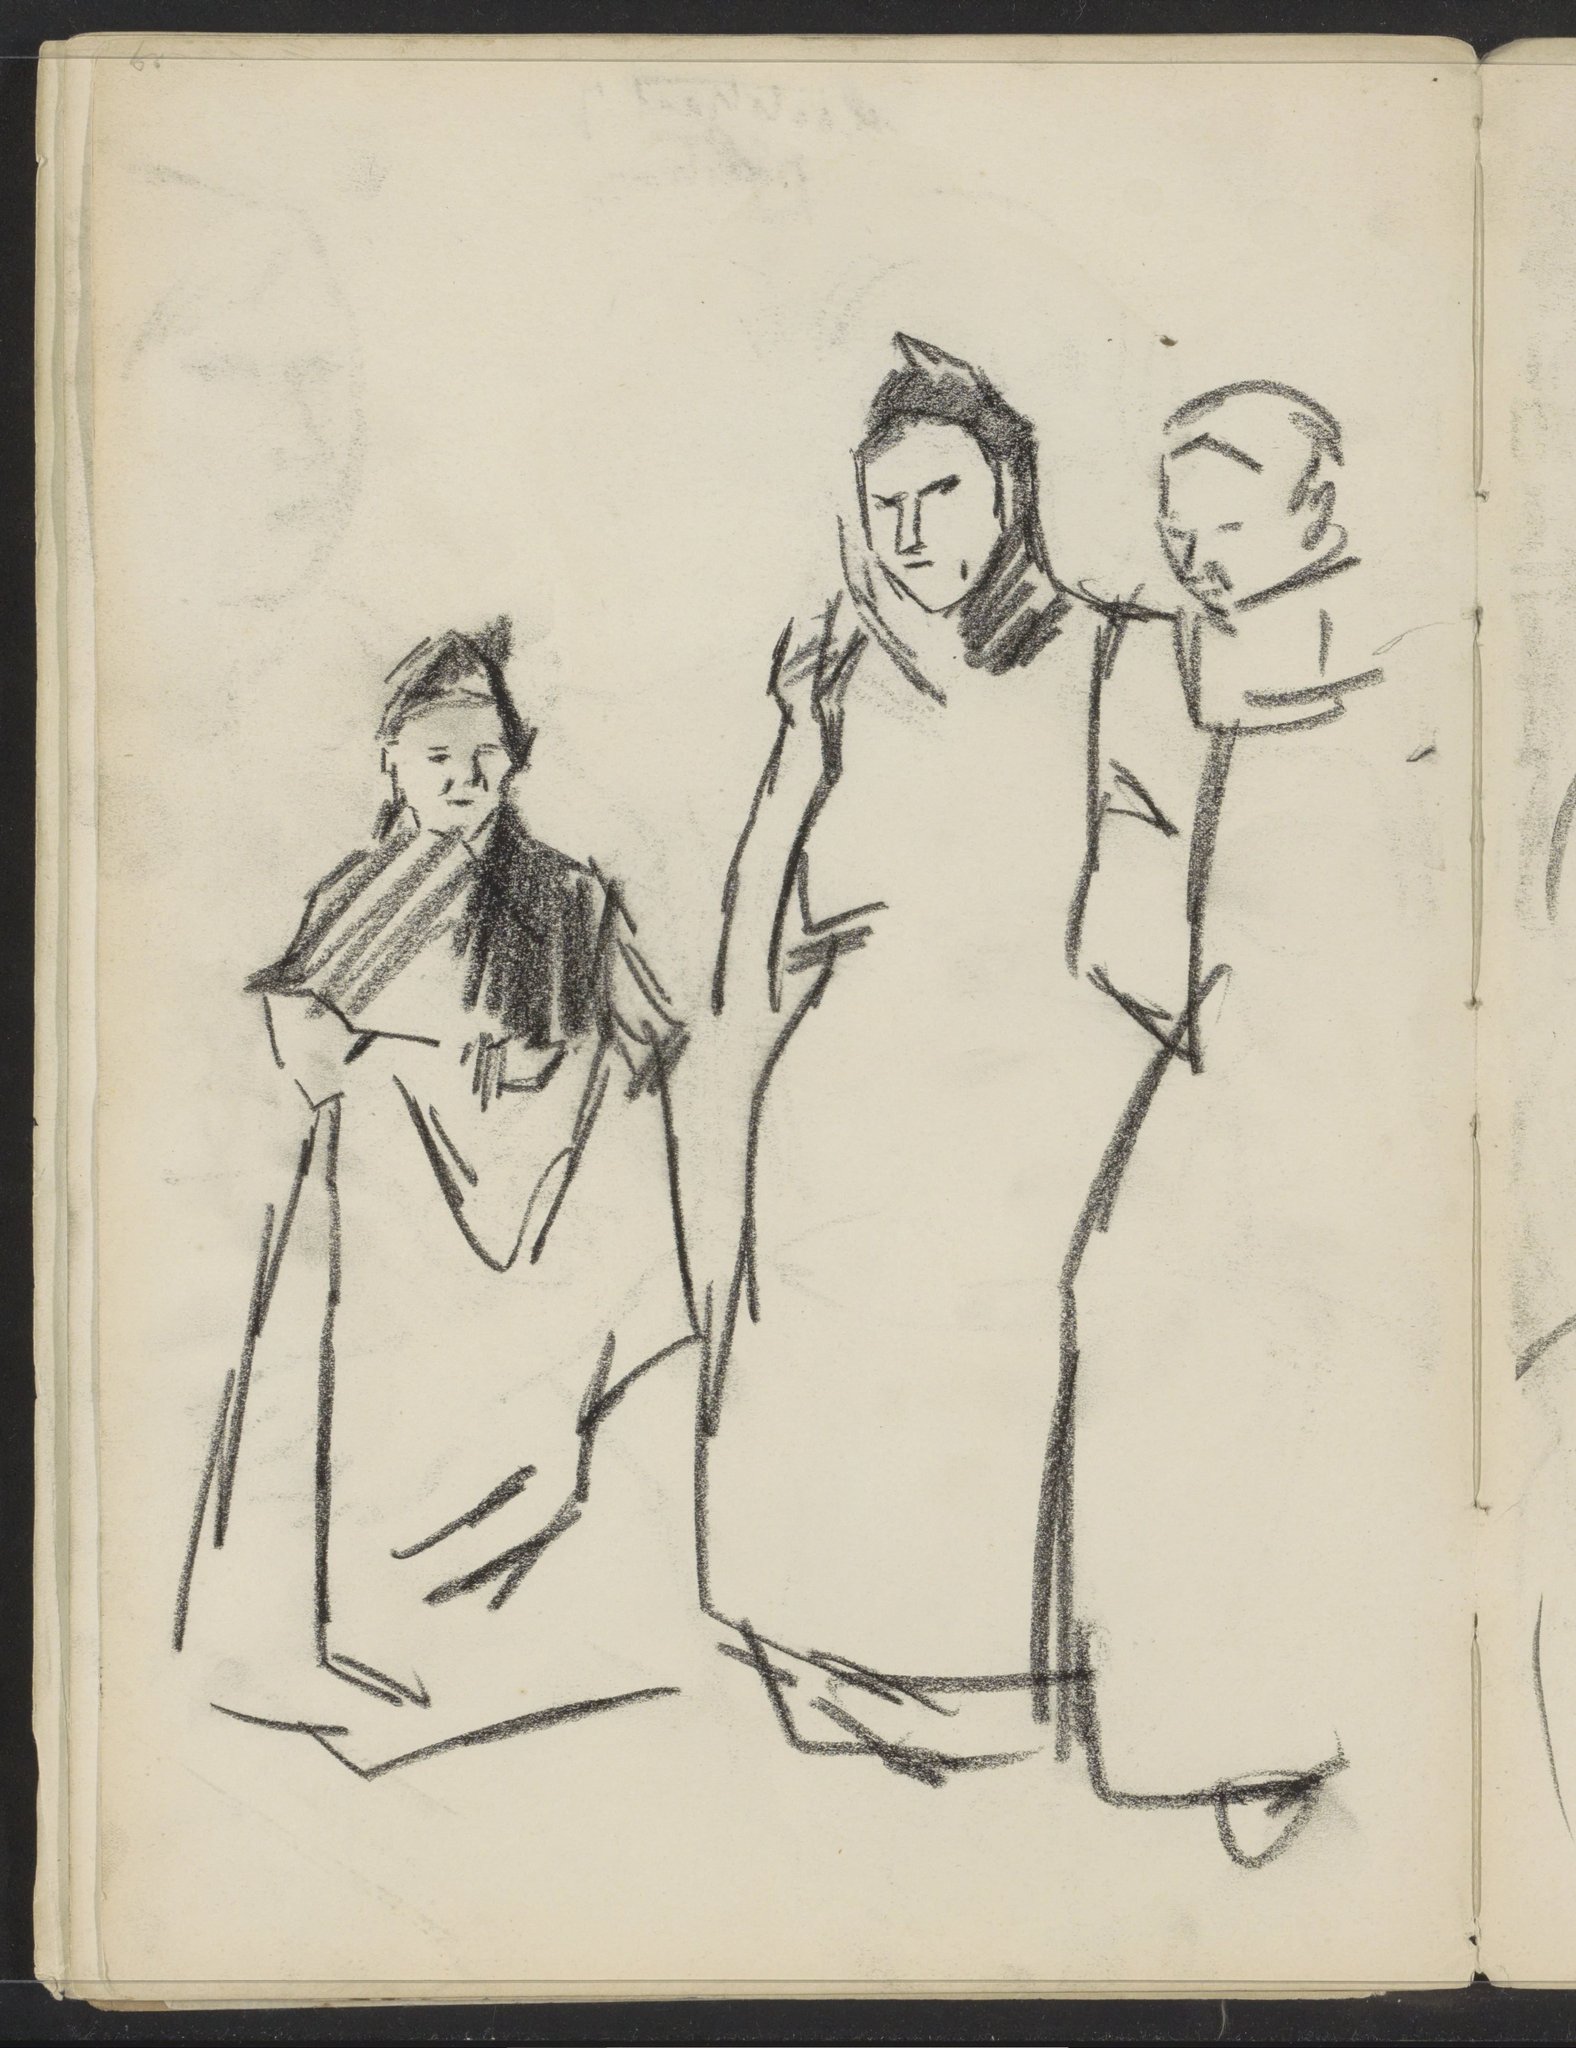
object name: sketchbook leaf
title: Drie staande vrouwen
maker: isaac israels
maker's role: draughtsman, painter, print maker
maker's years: 1865-1934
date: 1886-1934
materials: chalk, paper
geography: amsterdam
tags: adult woman (+ standing)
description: Blad 22 verso uit schetsboek LXVI-B met 25 bladen.